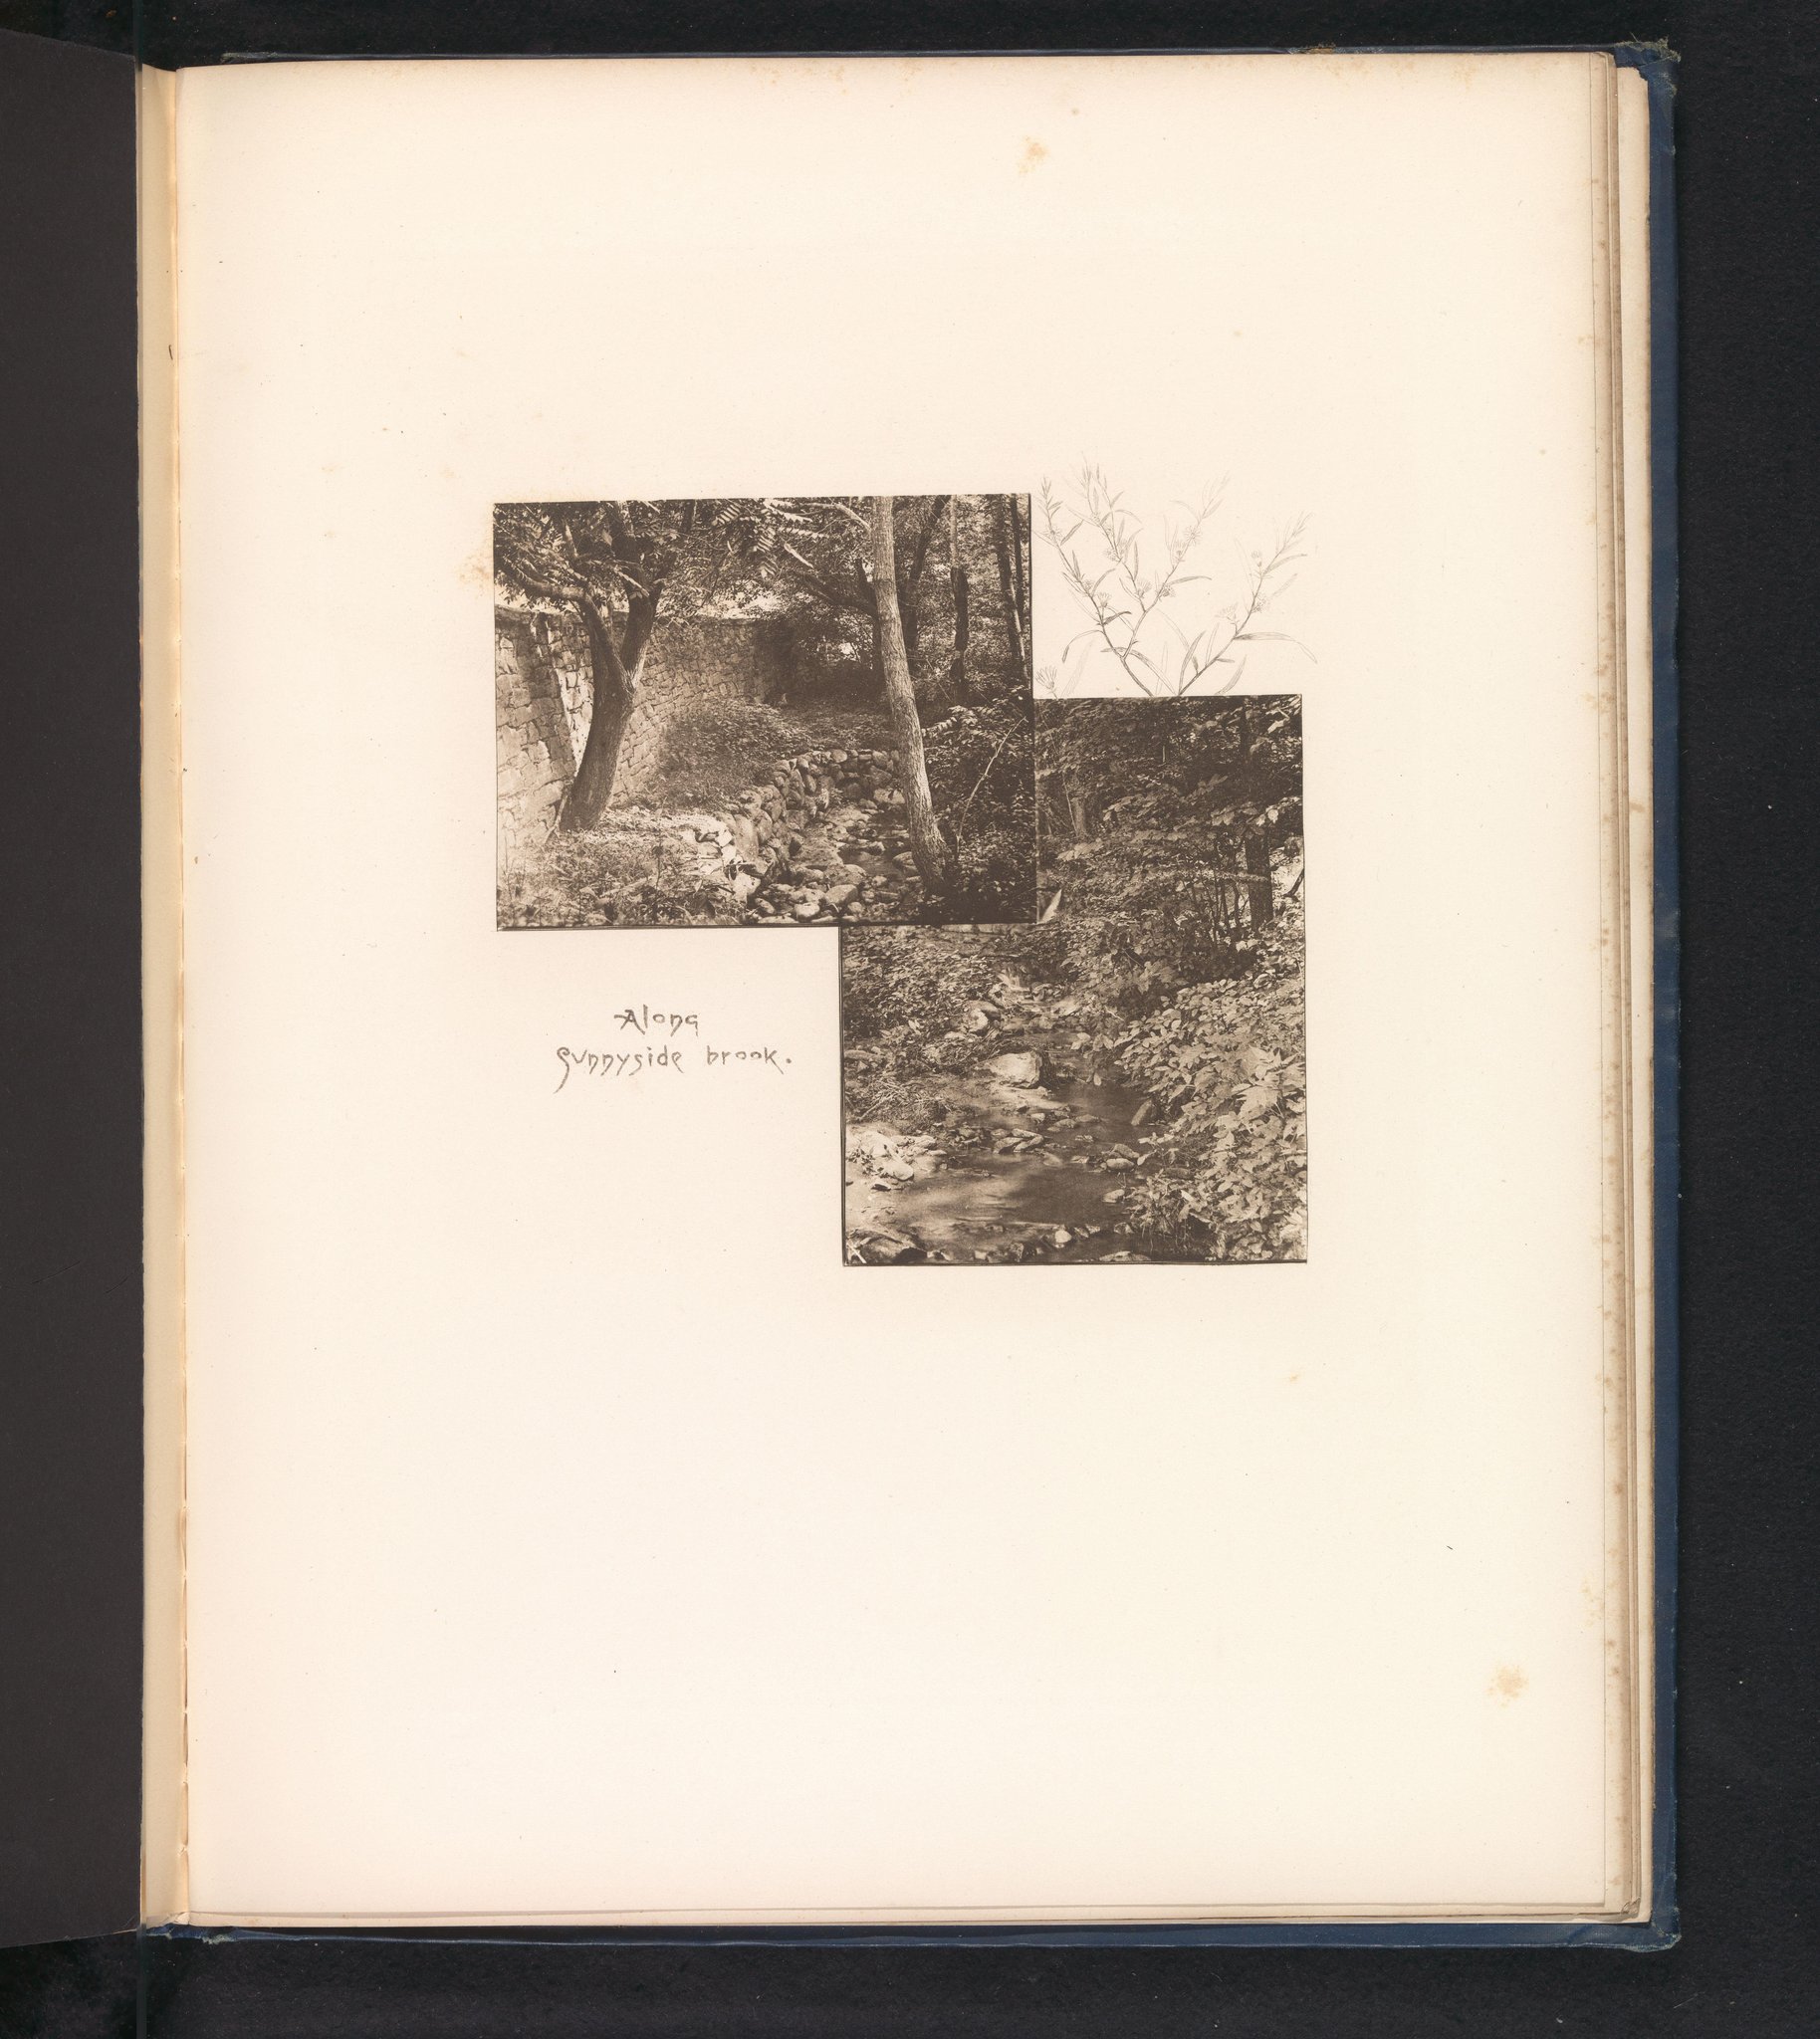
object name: page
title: Twee gezichten op een beek bij Sunnyside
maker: james leon williams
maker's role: fotograaf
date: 1882-1887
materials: paper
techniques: photoaquatint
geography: new york city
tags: brook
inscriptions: inscription: ‘Along Sunnyside brook’